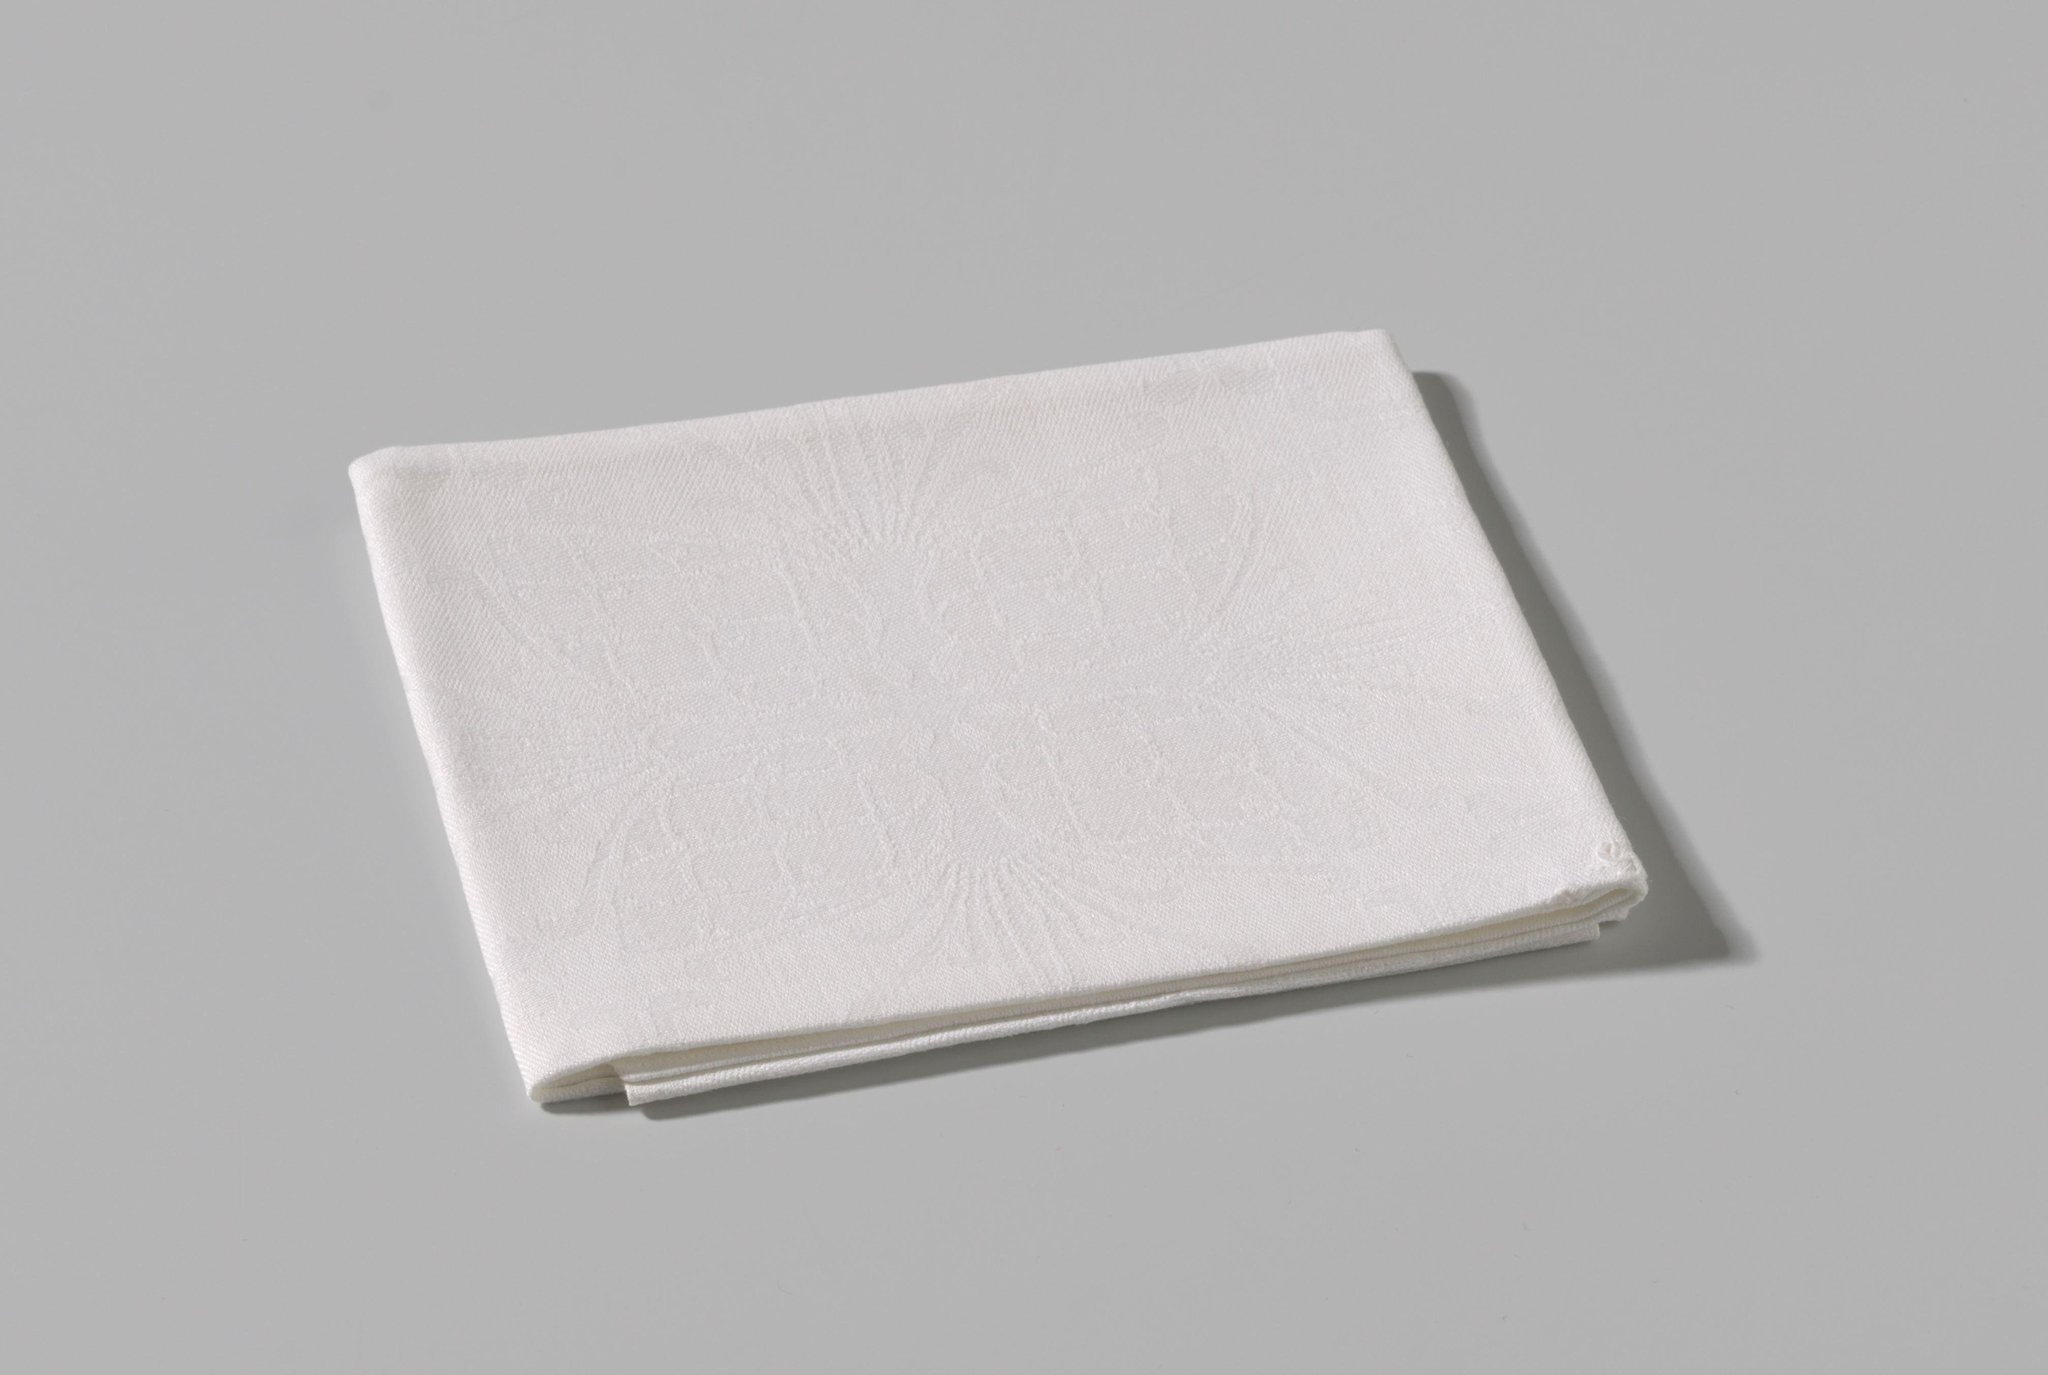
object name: vingerdoek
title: Vingerdoek van linnendamast motief Naaldenveld, dessin 607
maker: chris lebeau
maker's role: draughtsman, print maker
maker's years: 1878-1945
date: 1900-1925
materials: linen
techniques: damask, weave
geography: eindhoven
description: Vingerdoek van linnendamast met dessin 607; motief "naaldenveld". De vingerdoek hoort bij elf vingerdoeken (BK-1973-179-A t/m BK-1973-178-L) en een tafellaken (BK-1973-178).